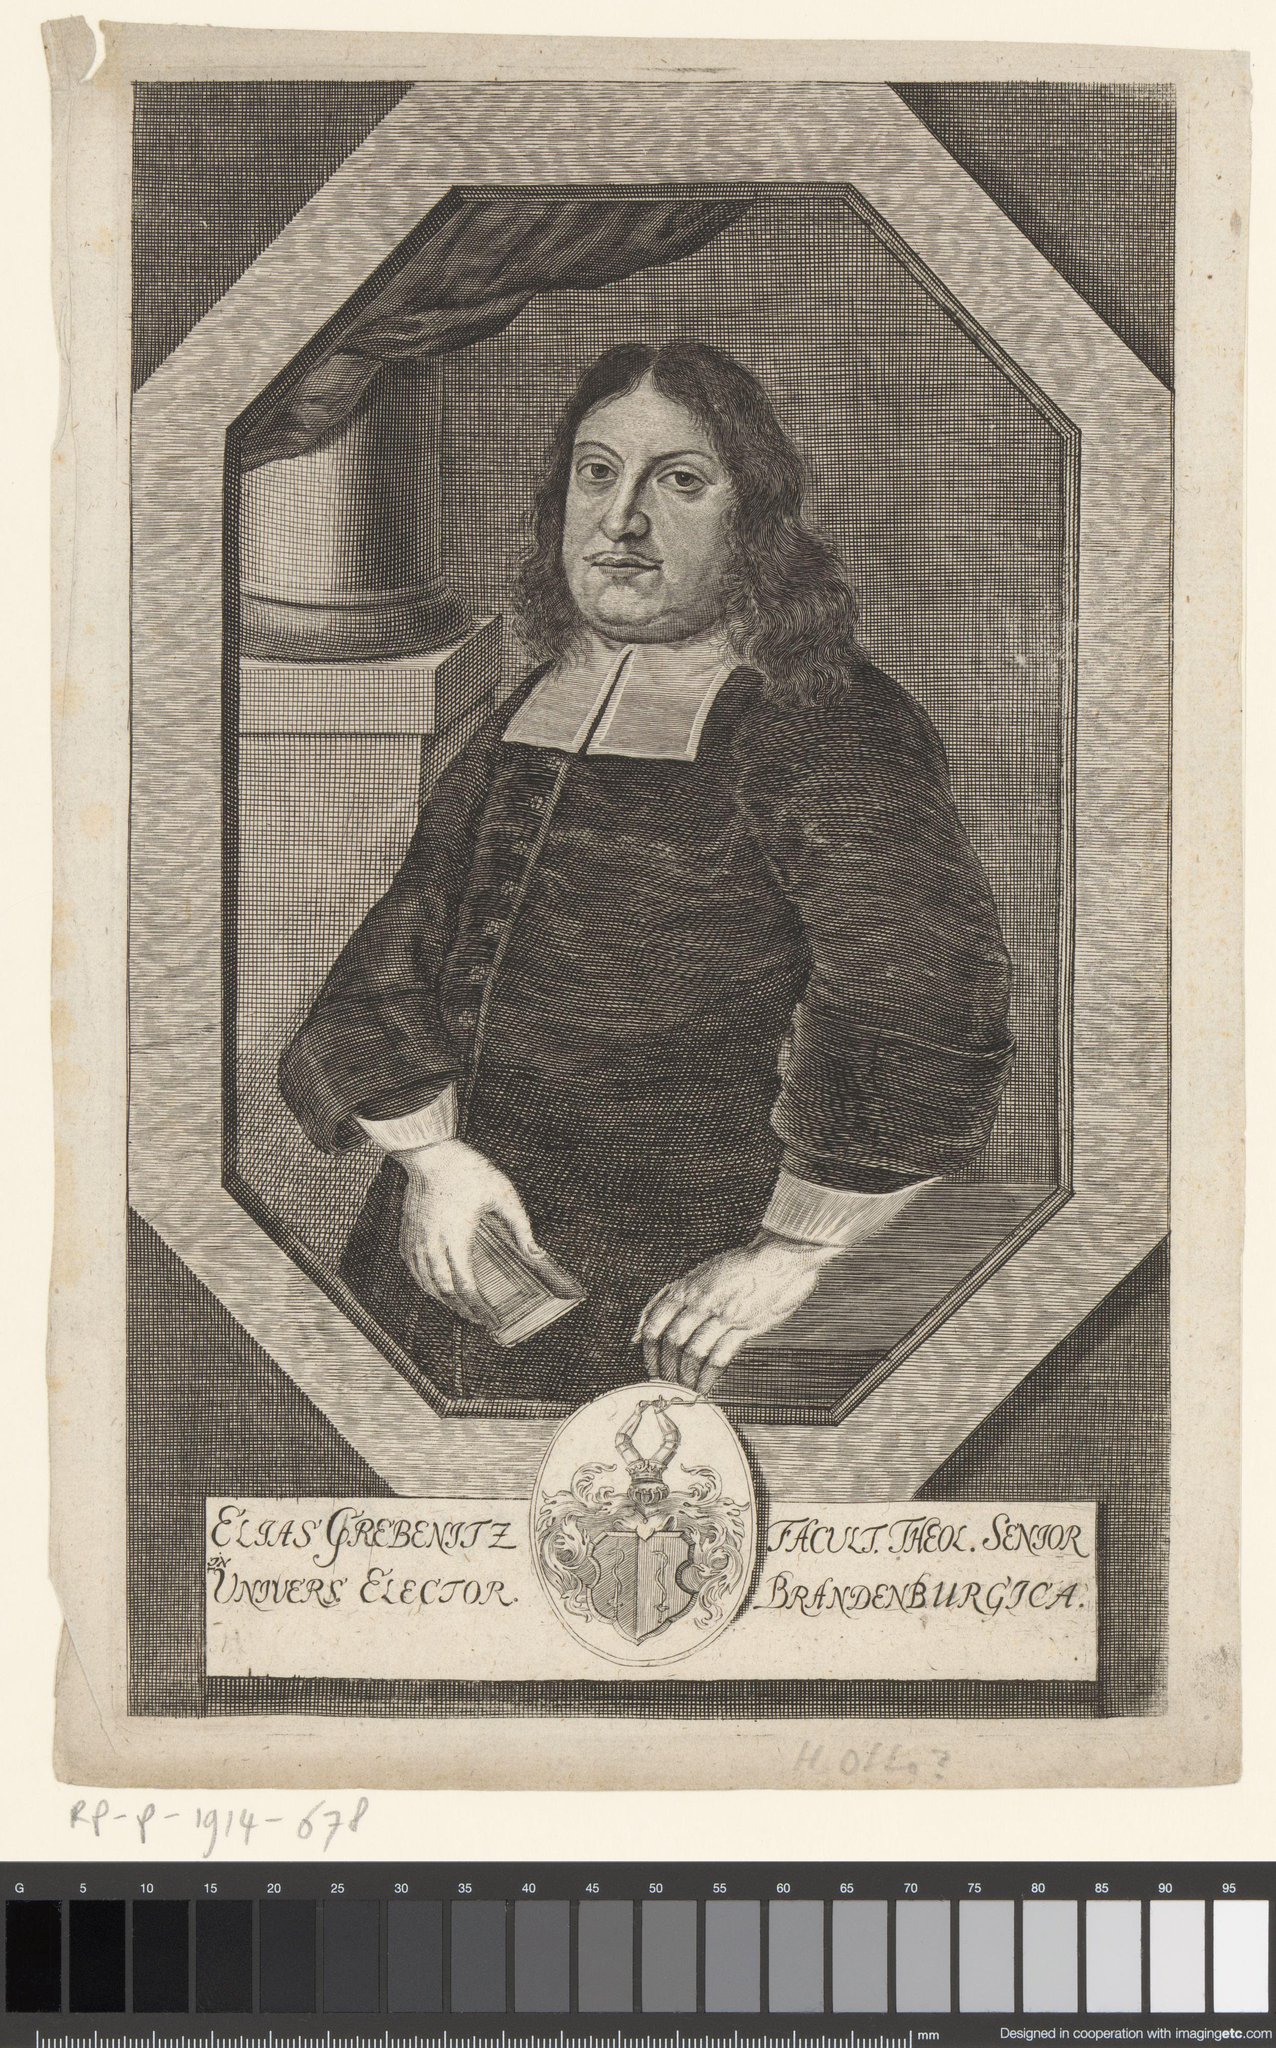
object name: print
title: Portret van Elias Grebenitz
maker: heinrich jakob otto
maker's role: print maker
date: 1650-1749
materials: paper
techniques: engraving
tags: historical persons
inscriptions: collector's mark: Lugt 2228